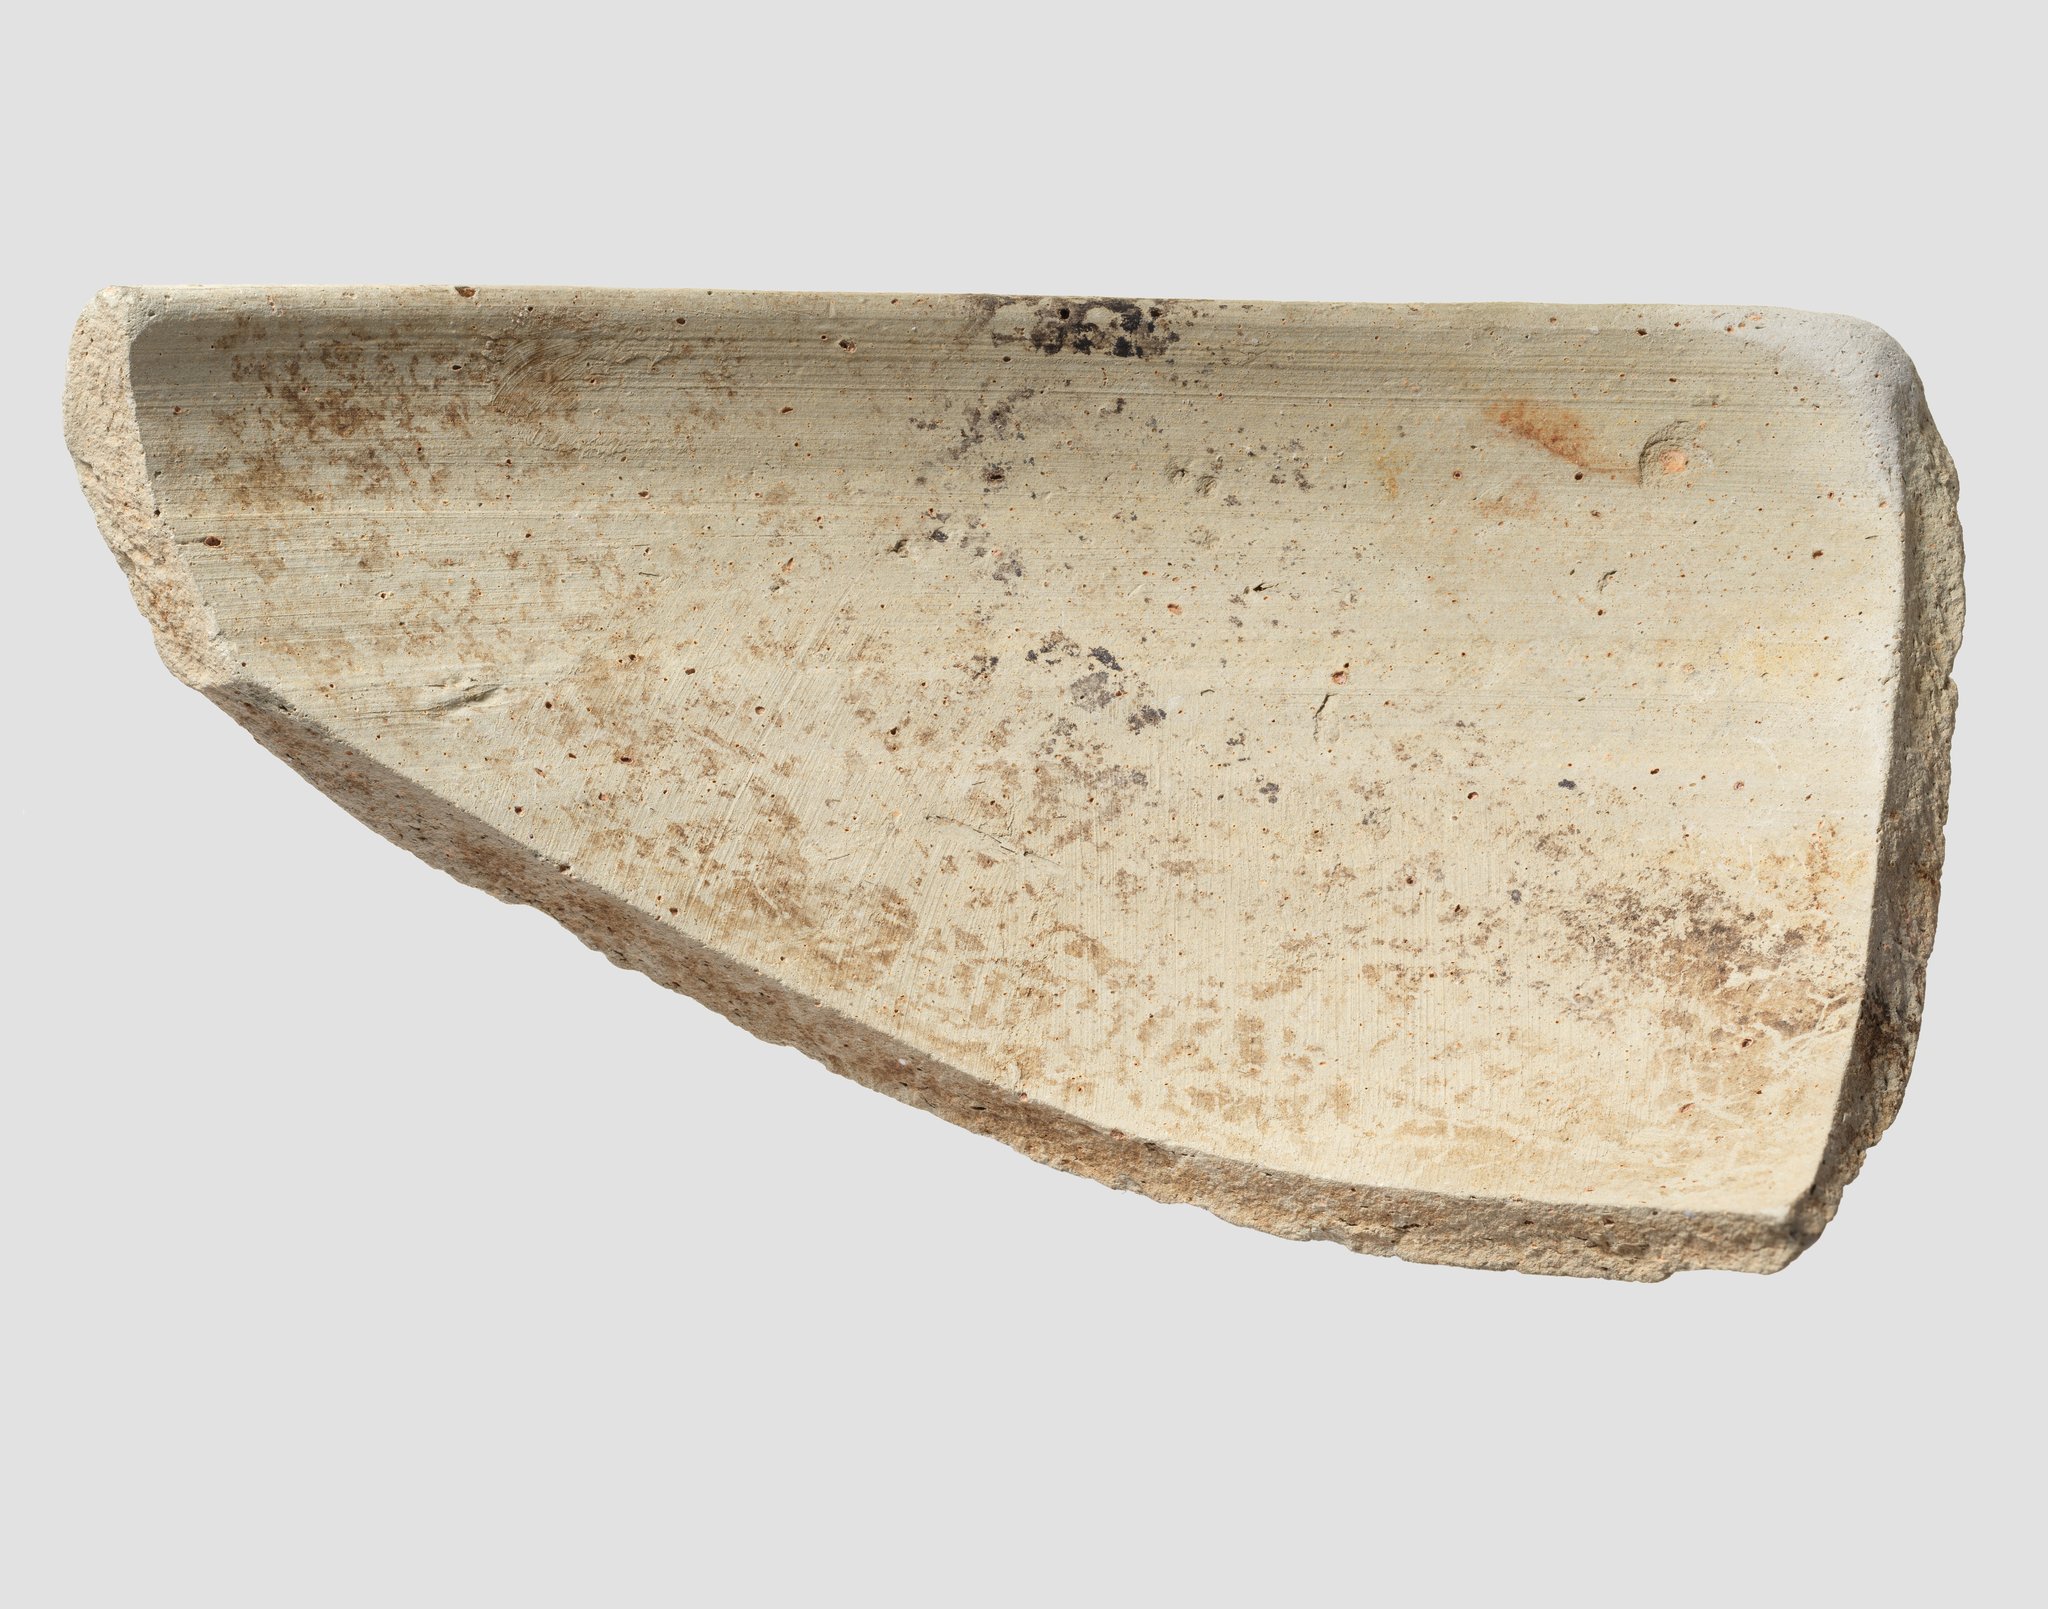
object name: bowl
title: Bowl sherd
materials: ceramic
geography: mesopotamia